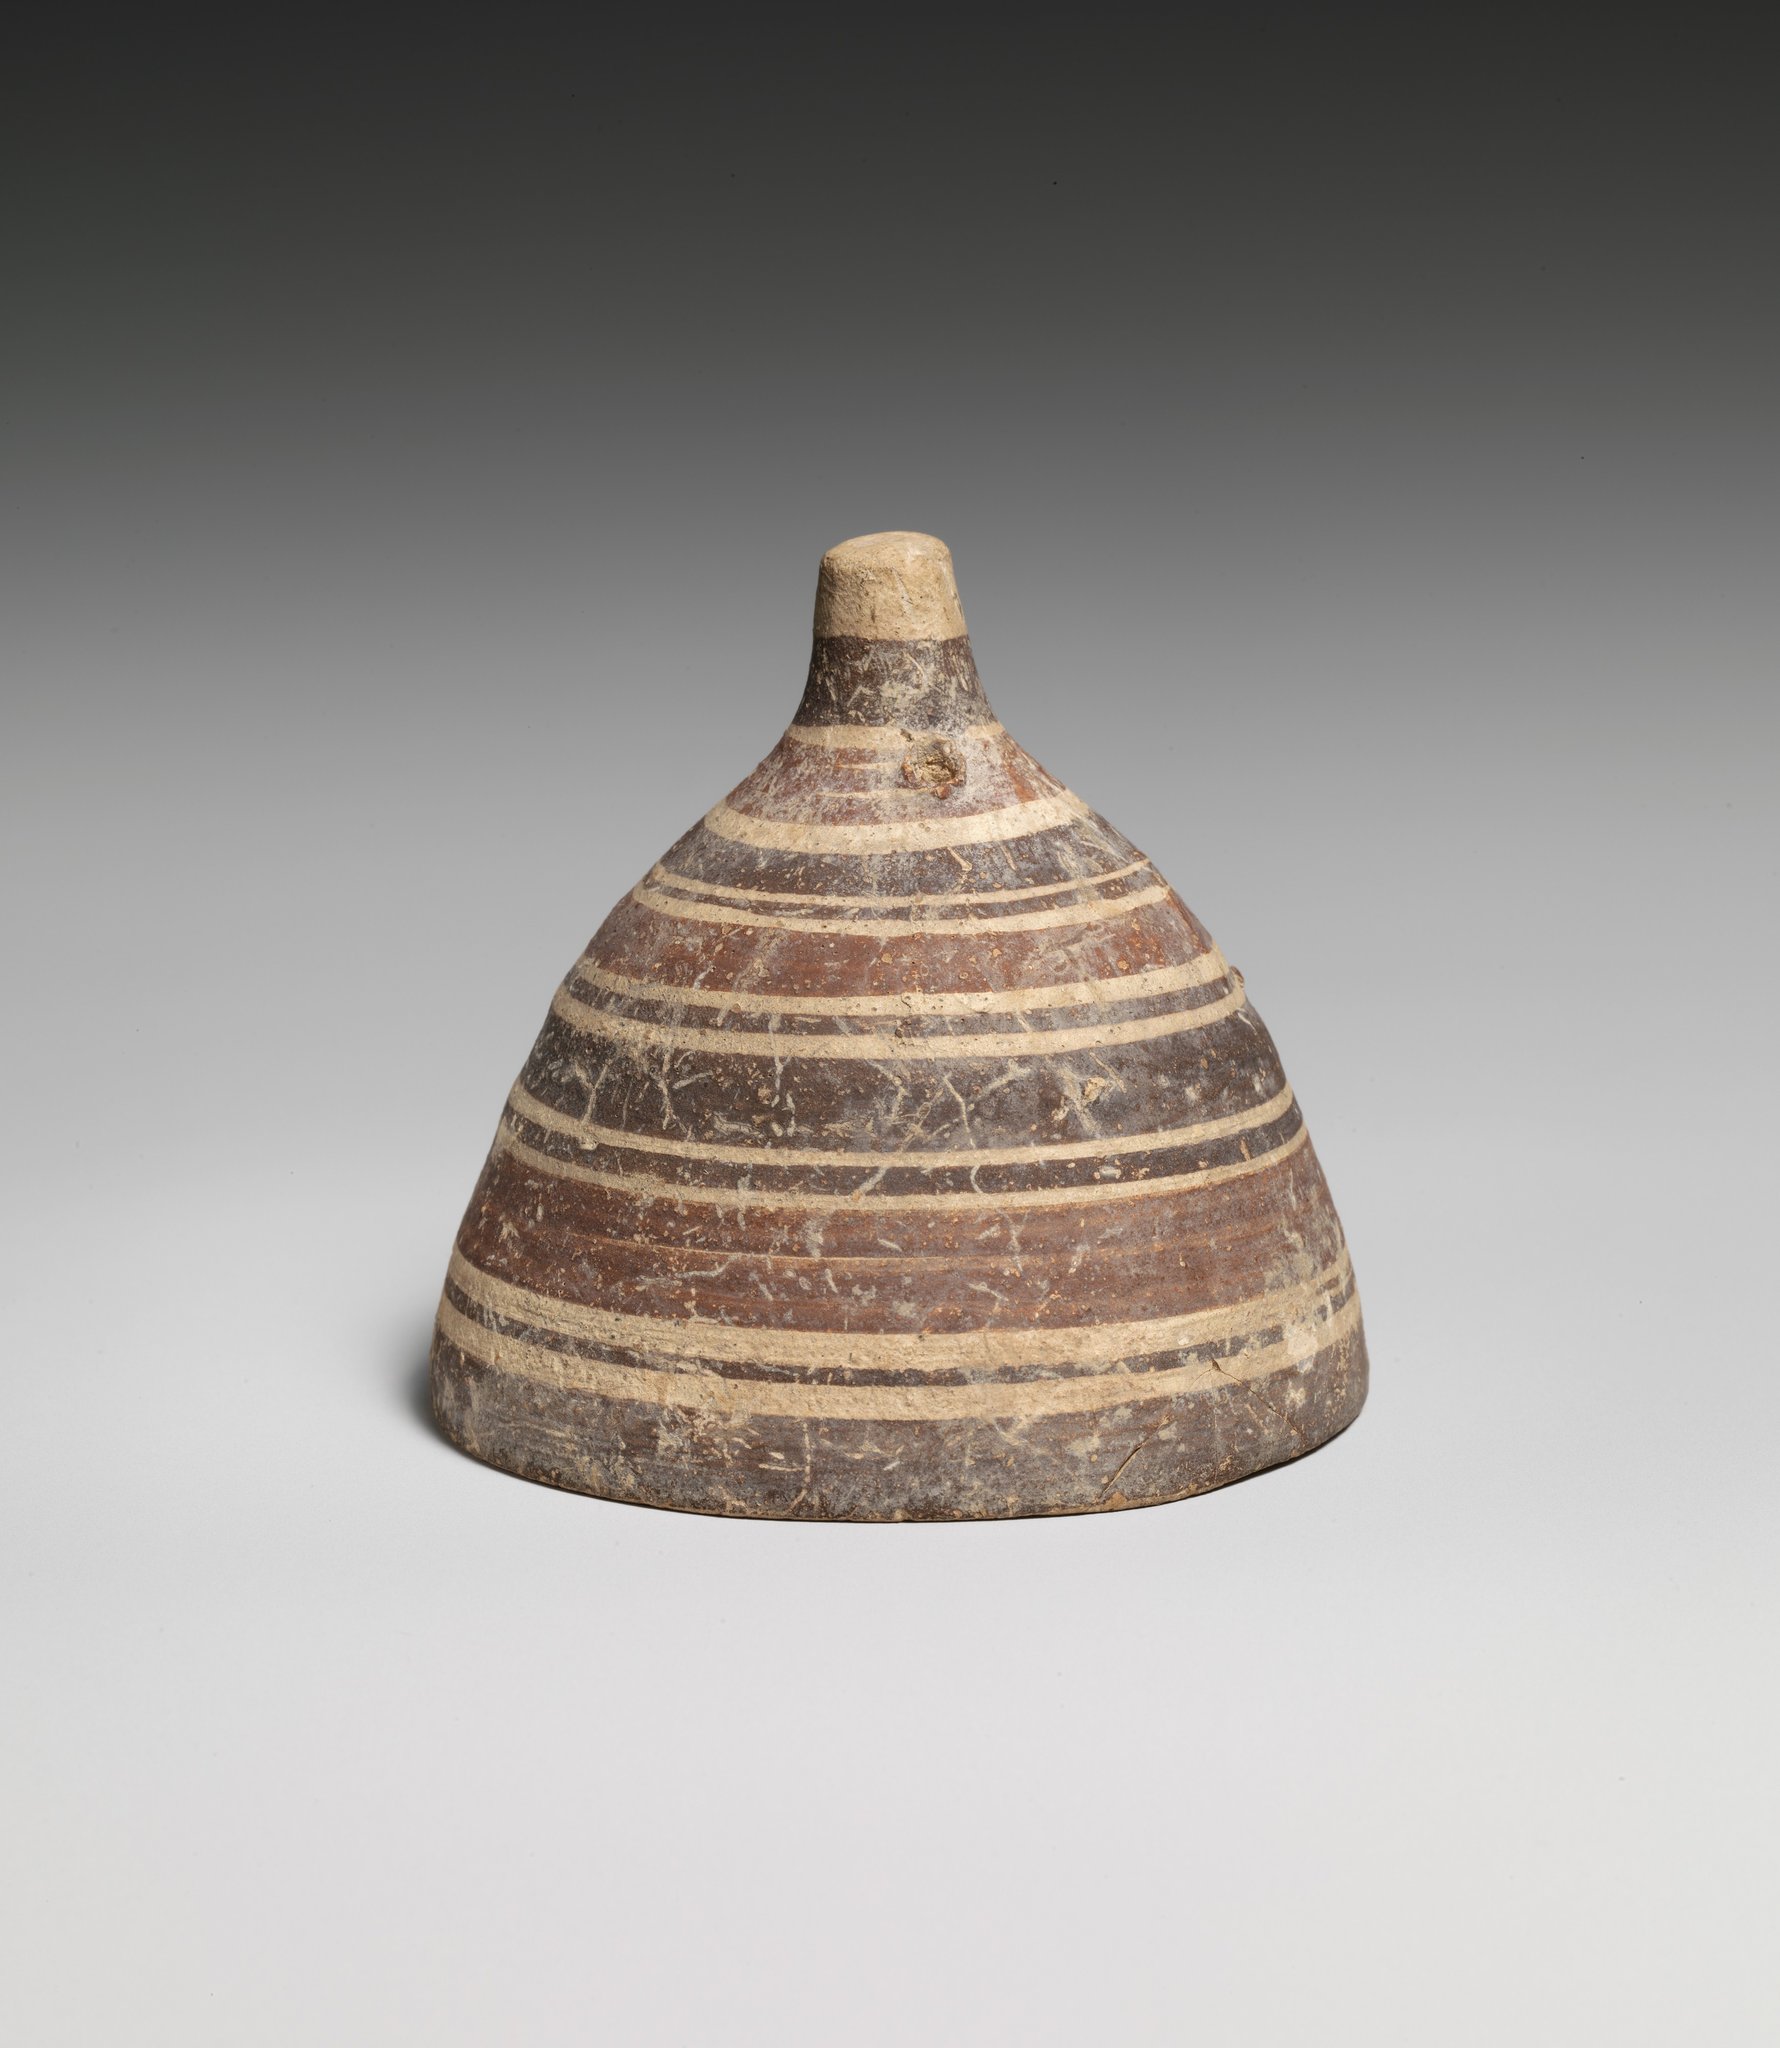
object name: bell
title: Terracotta bell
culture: cypriot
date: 600-480 BCE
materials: terracotta